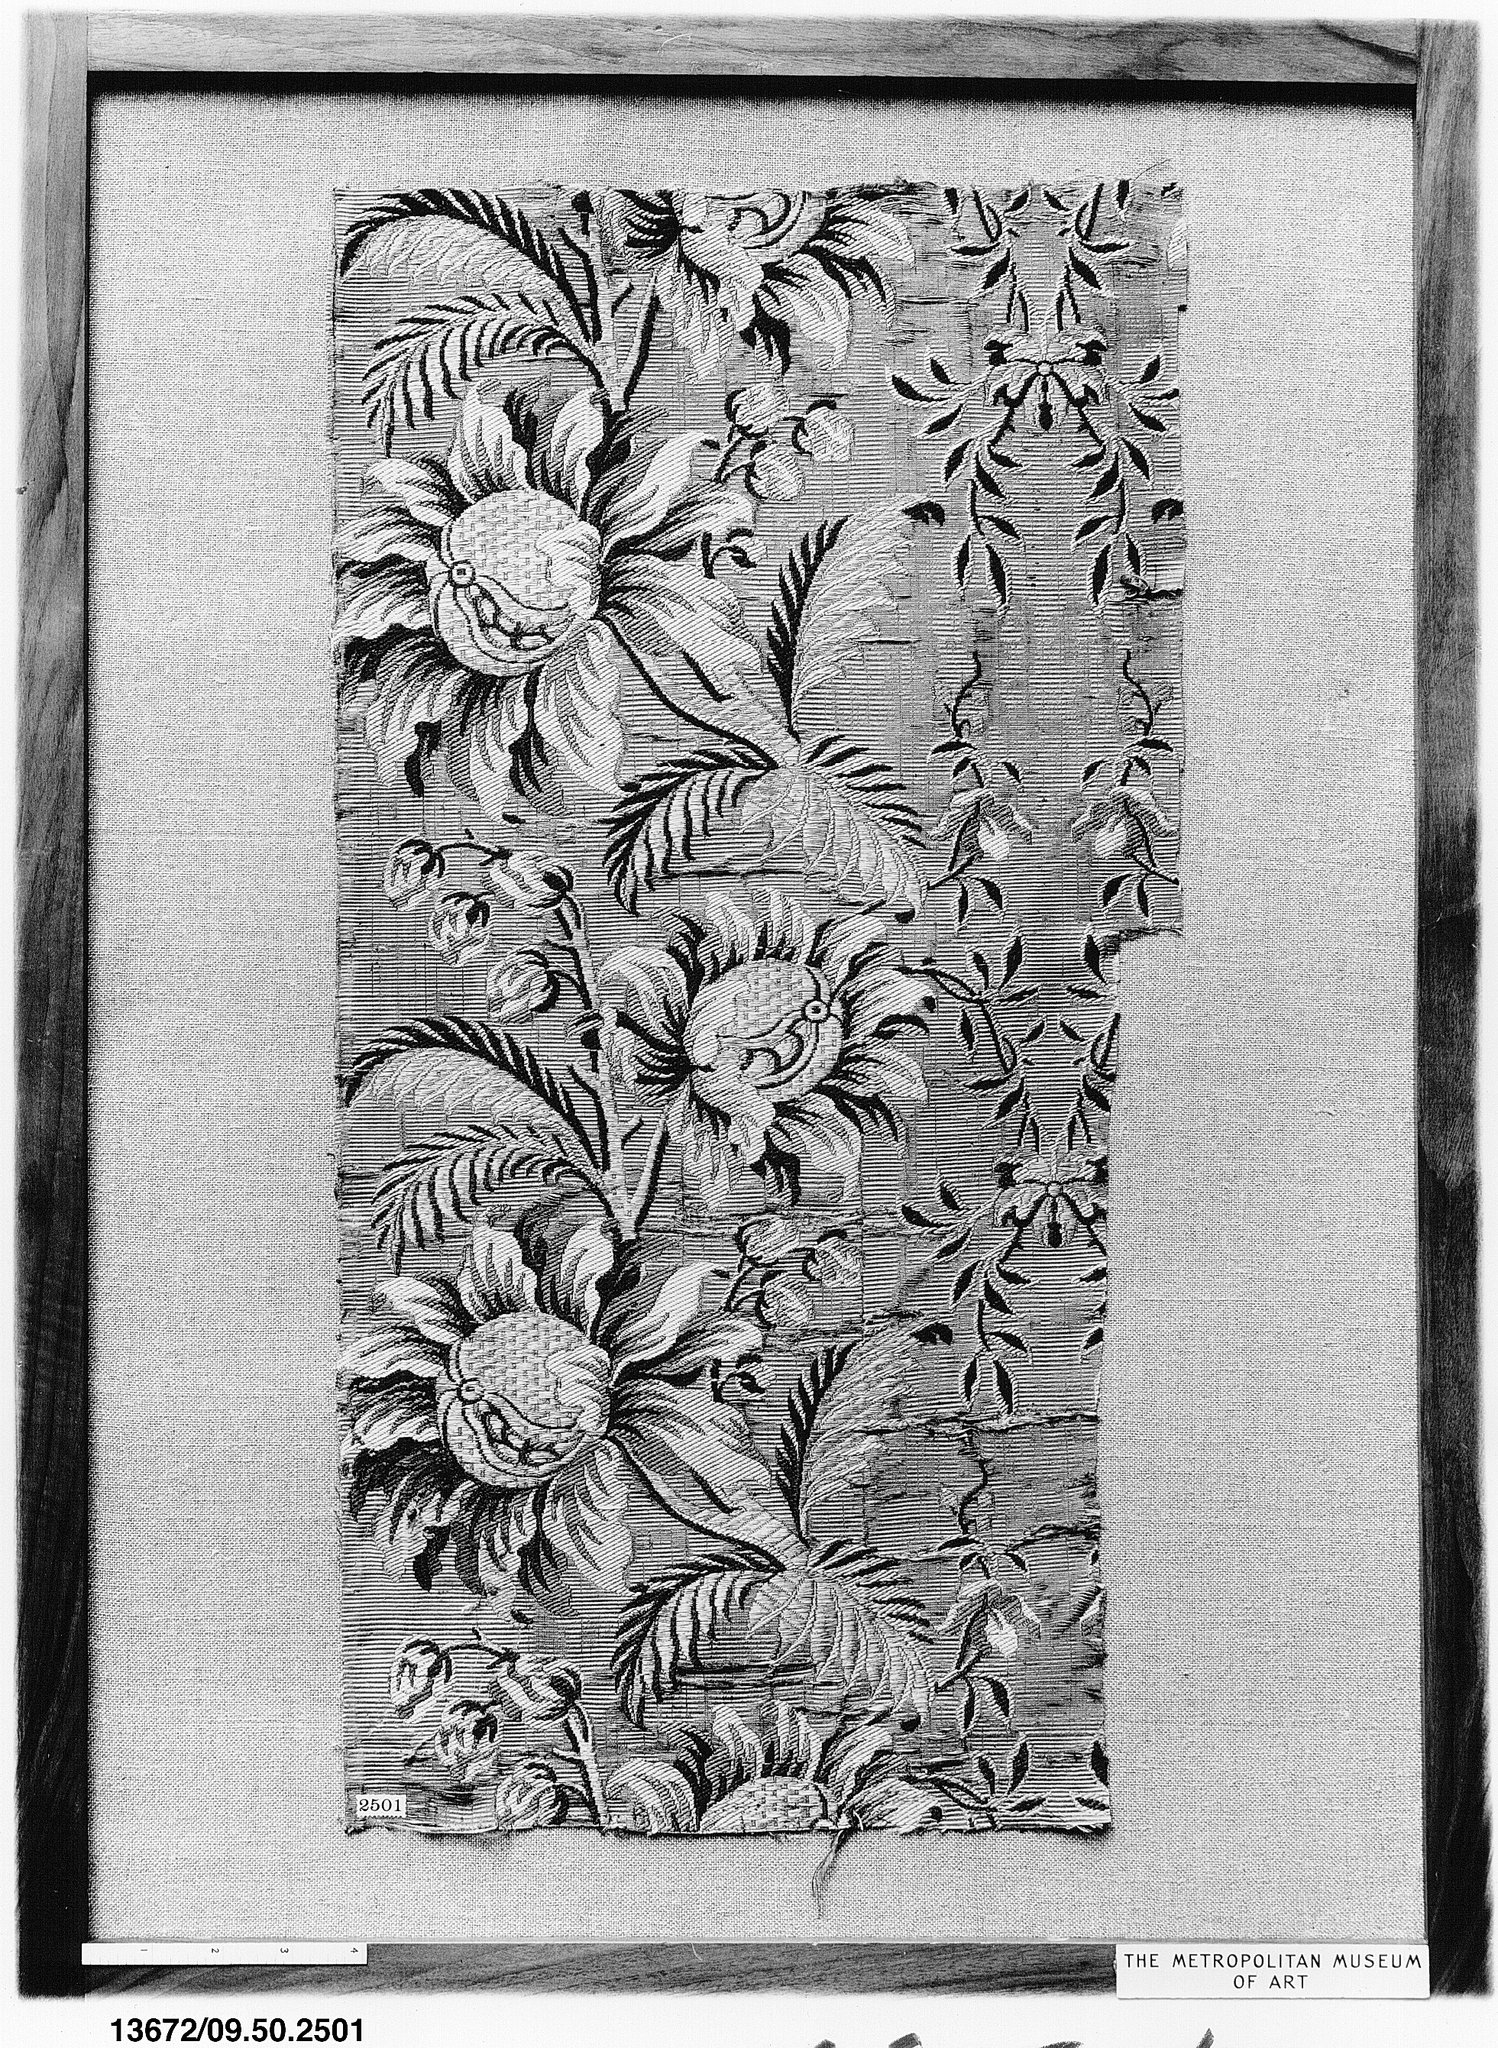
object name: piece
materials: metal thread, silk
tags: flowers,leaves